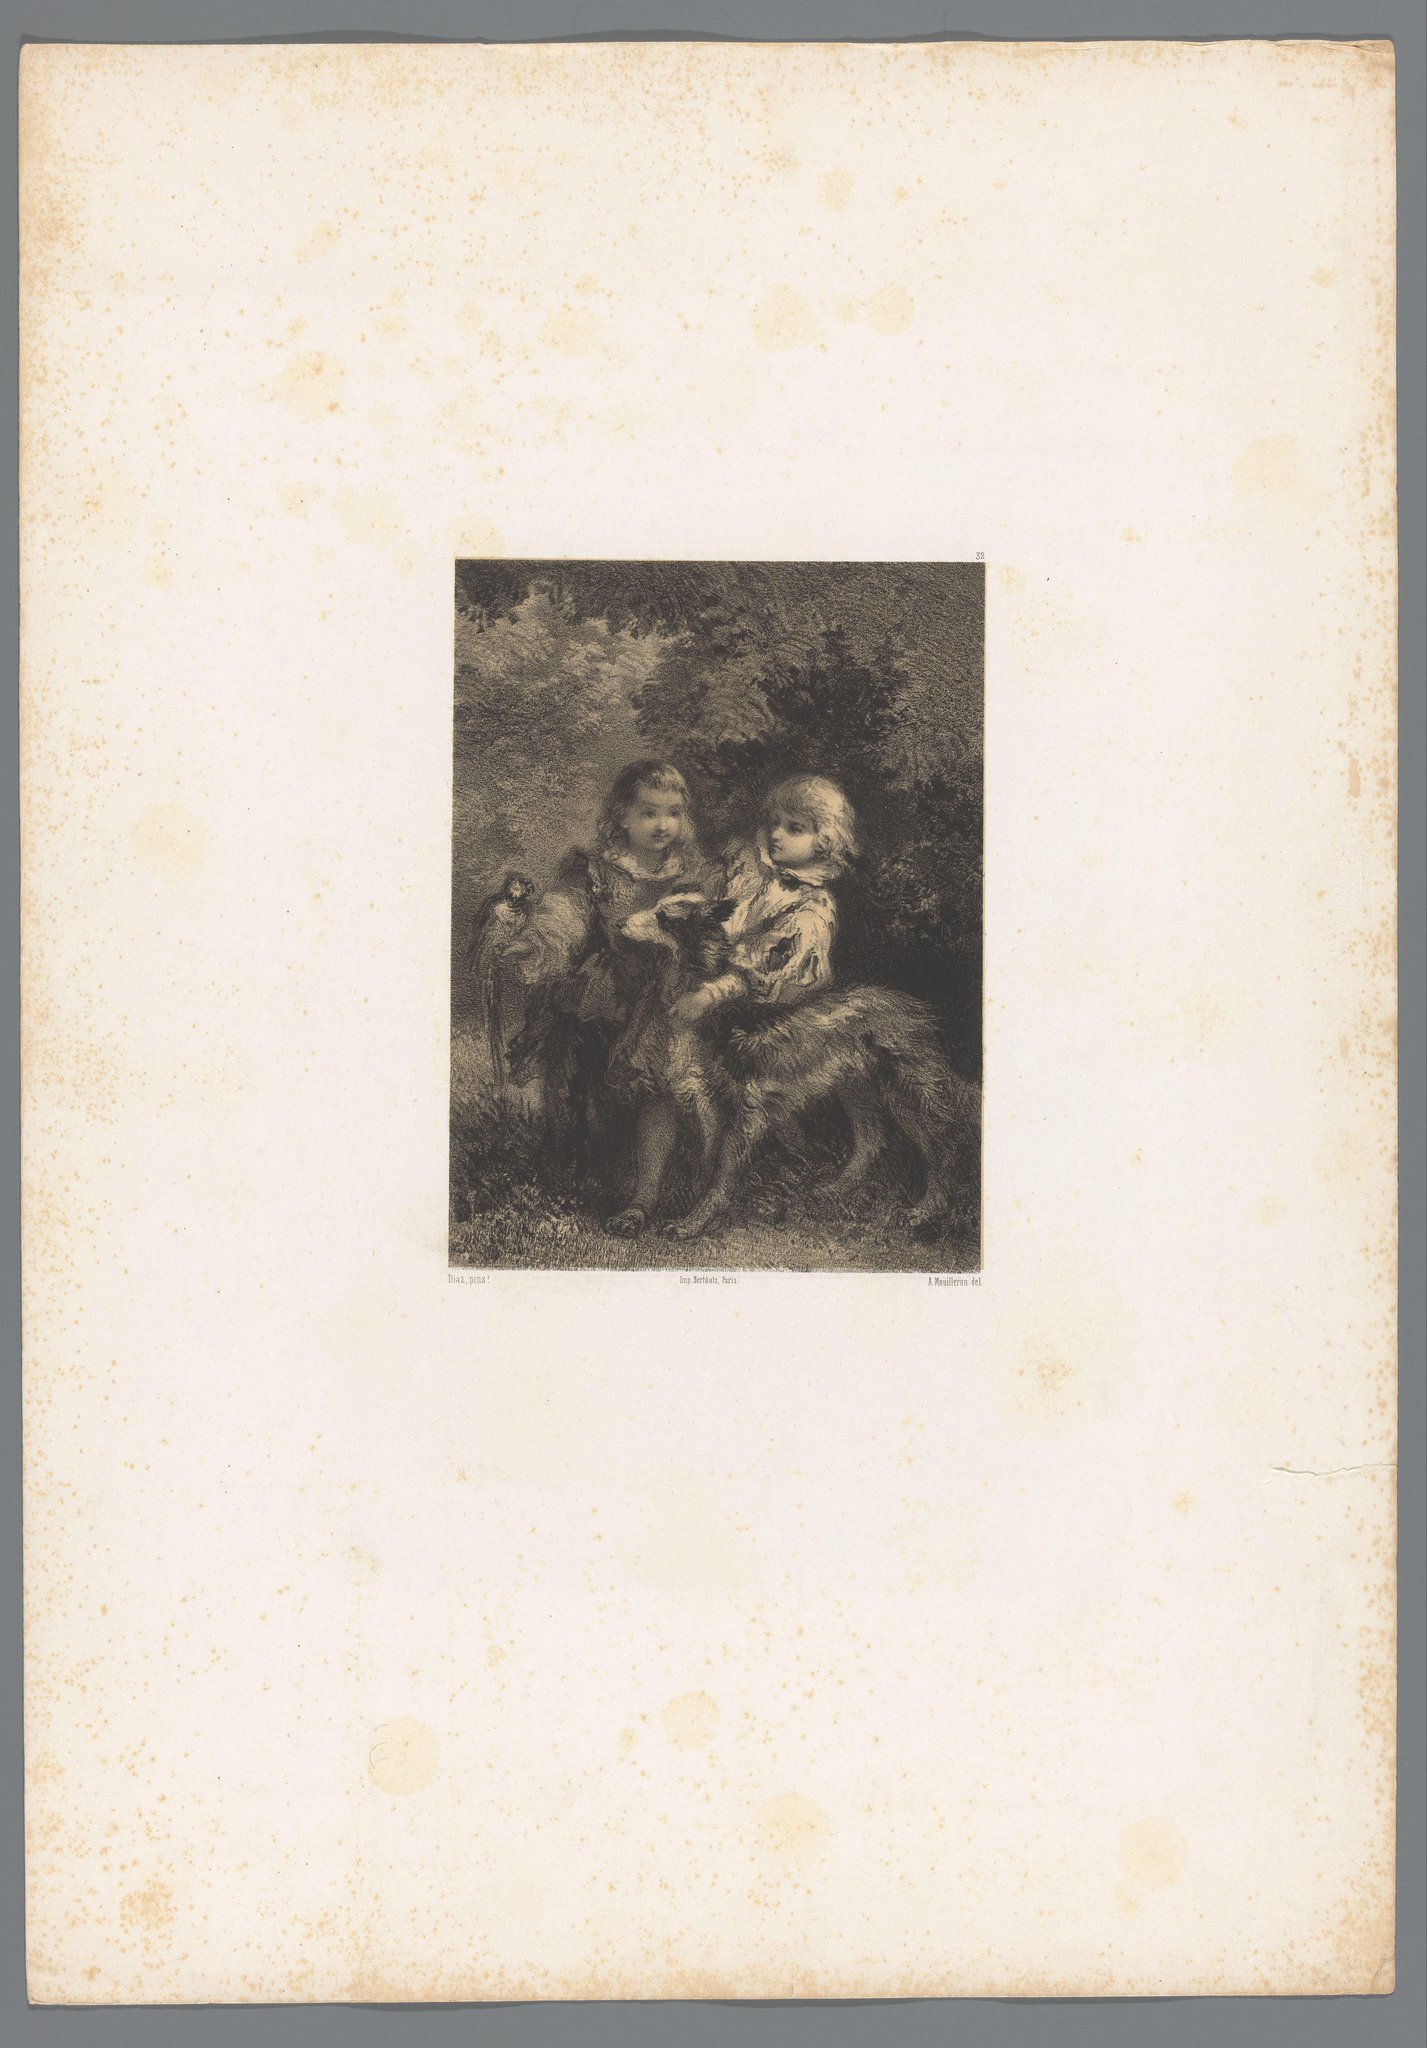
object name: print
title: Les artistes contemporains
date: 1846-1853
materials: paper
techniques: tone lithography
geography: paris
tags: ornamental birds: parrot, child, dog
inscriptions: collector's mark: Lugt 964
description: Serietitel gebaseerd op blindstempel op ander exemplaar van dezelfde staat in de collectie Rijksmuseum. Zie: RP-P-1913-609.